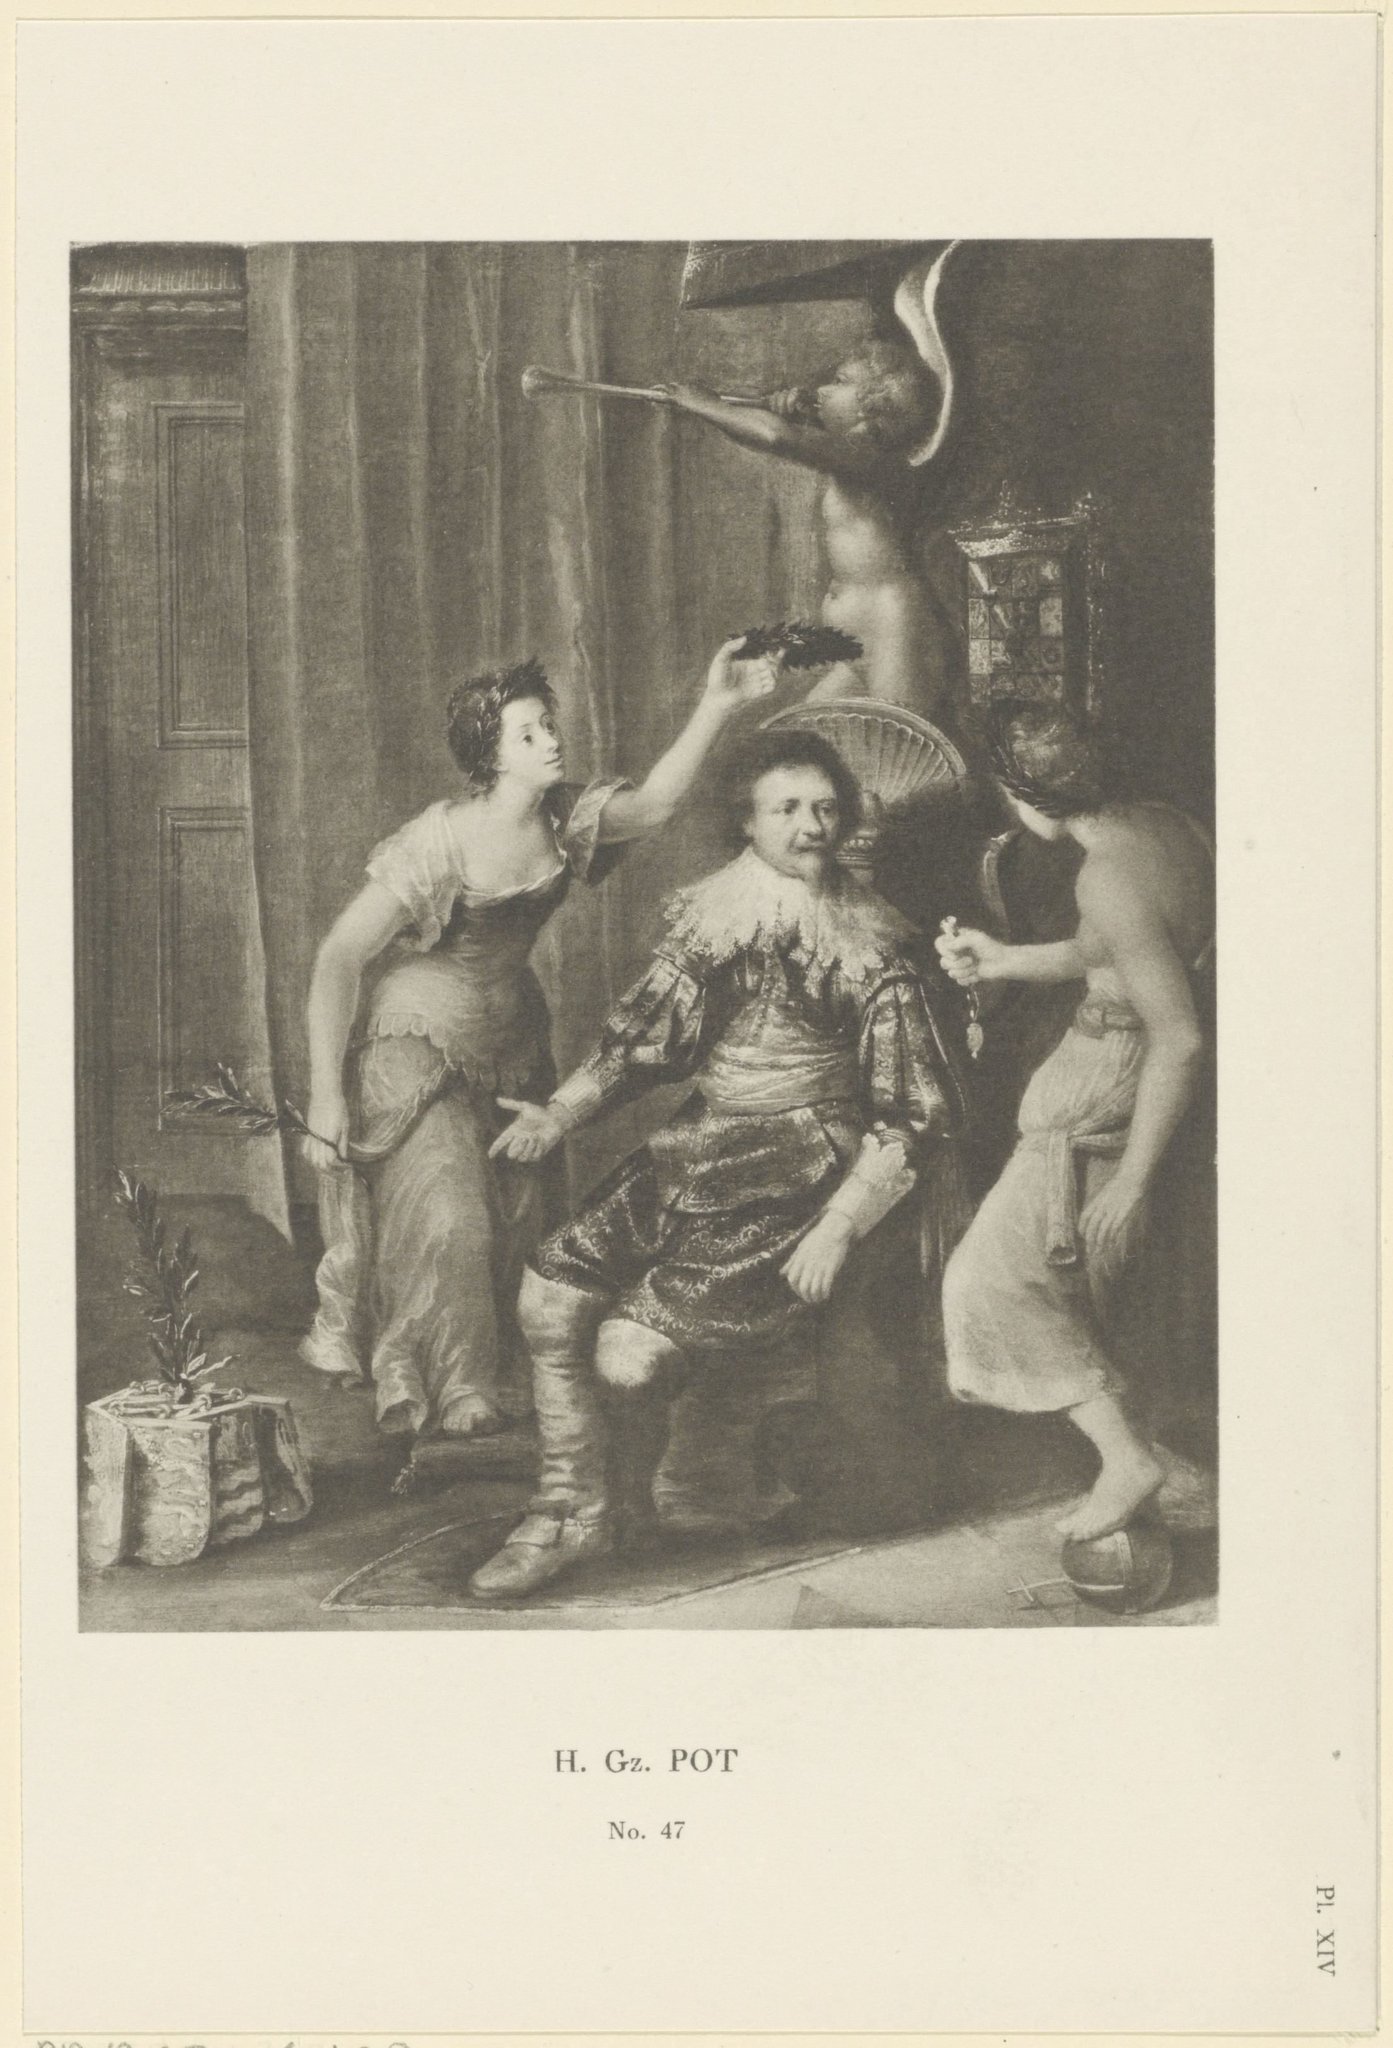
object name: photomechanical print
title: Portret van Frederik Hendrik, prins van Oranje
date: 1850-1949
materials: paper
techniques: photograph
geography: netherlands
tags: the hague, frederick henry (prince of orange)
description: Portret van Frederik Hendrik. Hij zit in een vertrek met aan de muur zijn wapen met een kroon. Rondom staan drie allegorische figuren. Een engel blaast op een bazuin en een figuur houdt een lauwerkrans boven zijn hoofd. Midden onder 'No. 47'. Rechtsonder 'Pl. XIV'.